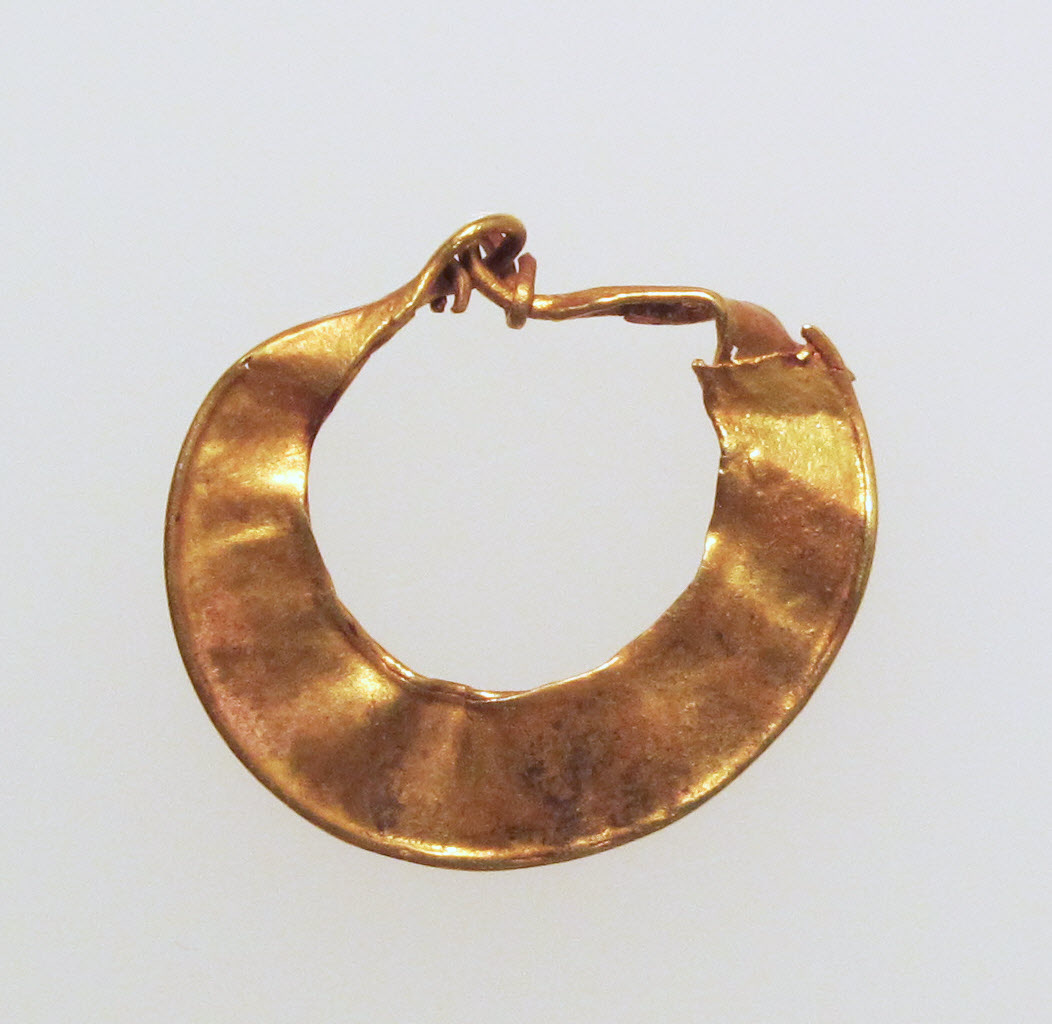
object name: earring, crescent shaped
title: Earring, crescent-shaped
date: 7000 BCE-330 CE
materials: gold